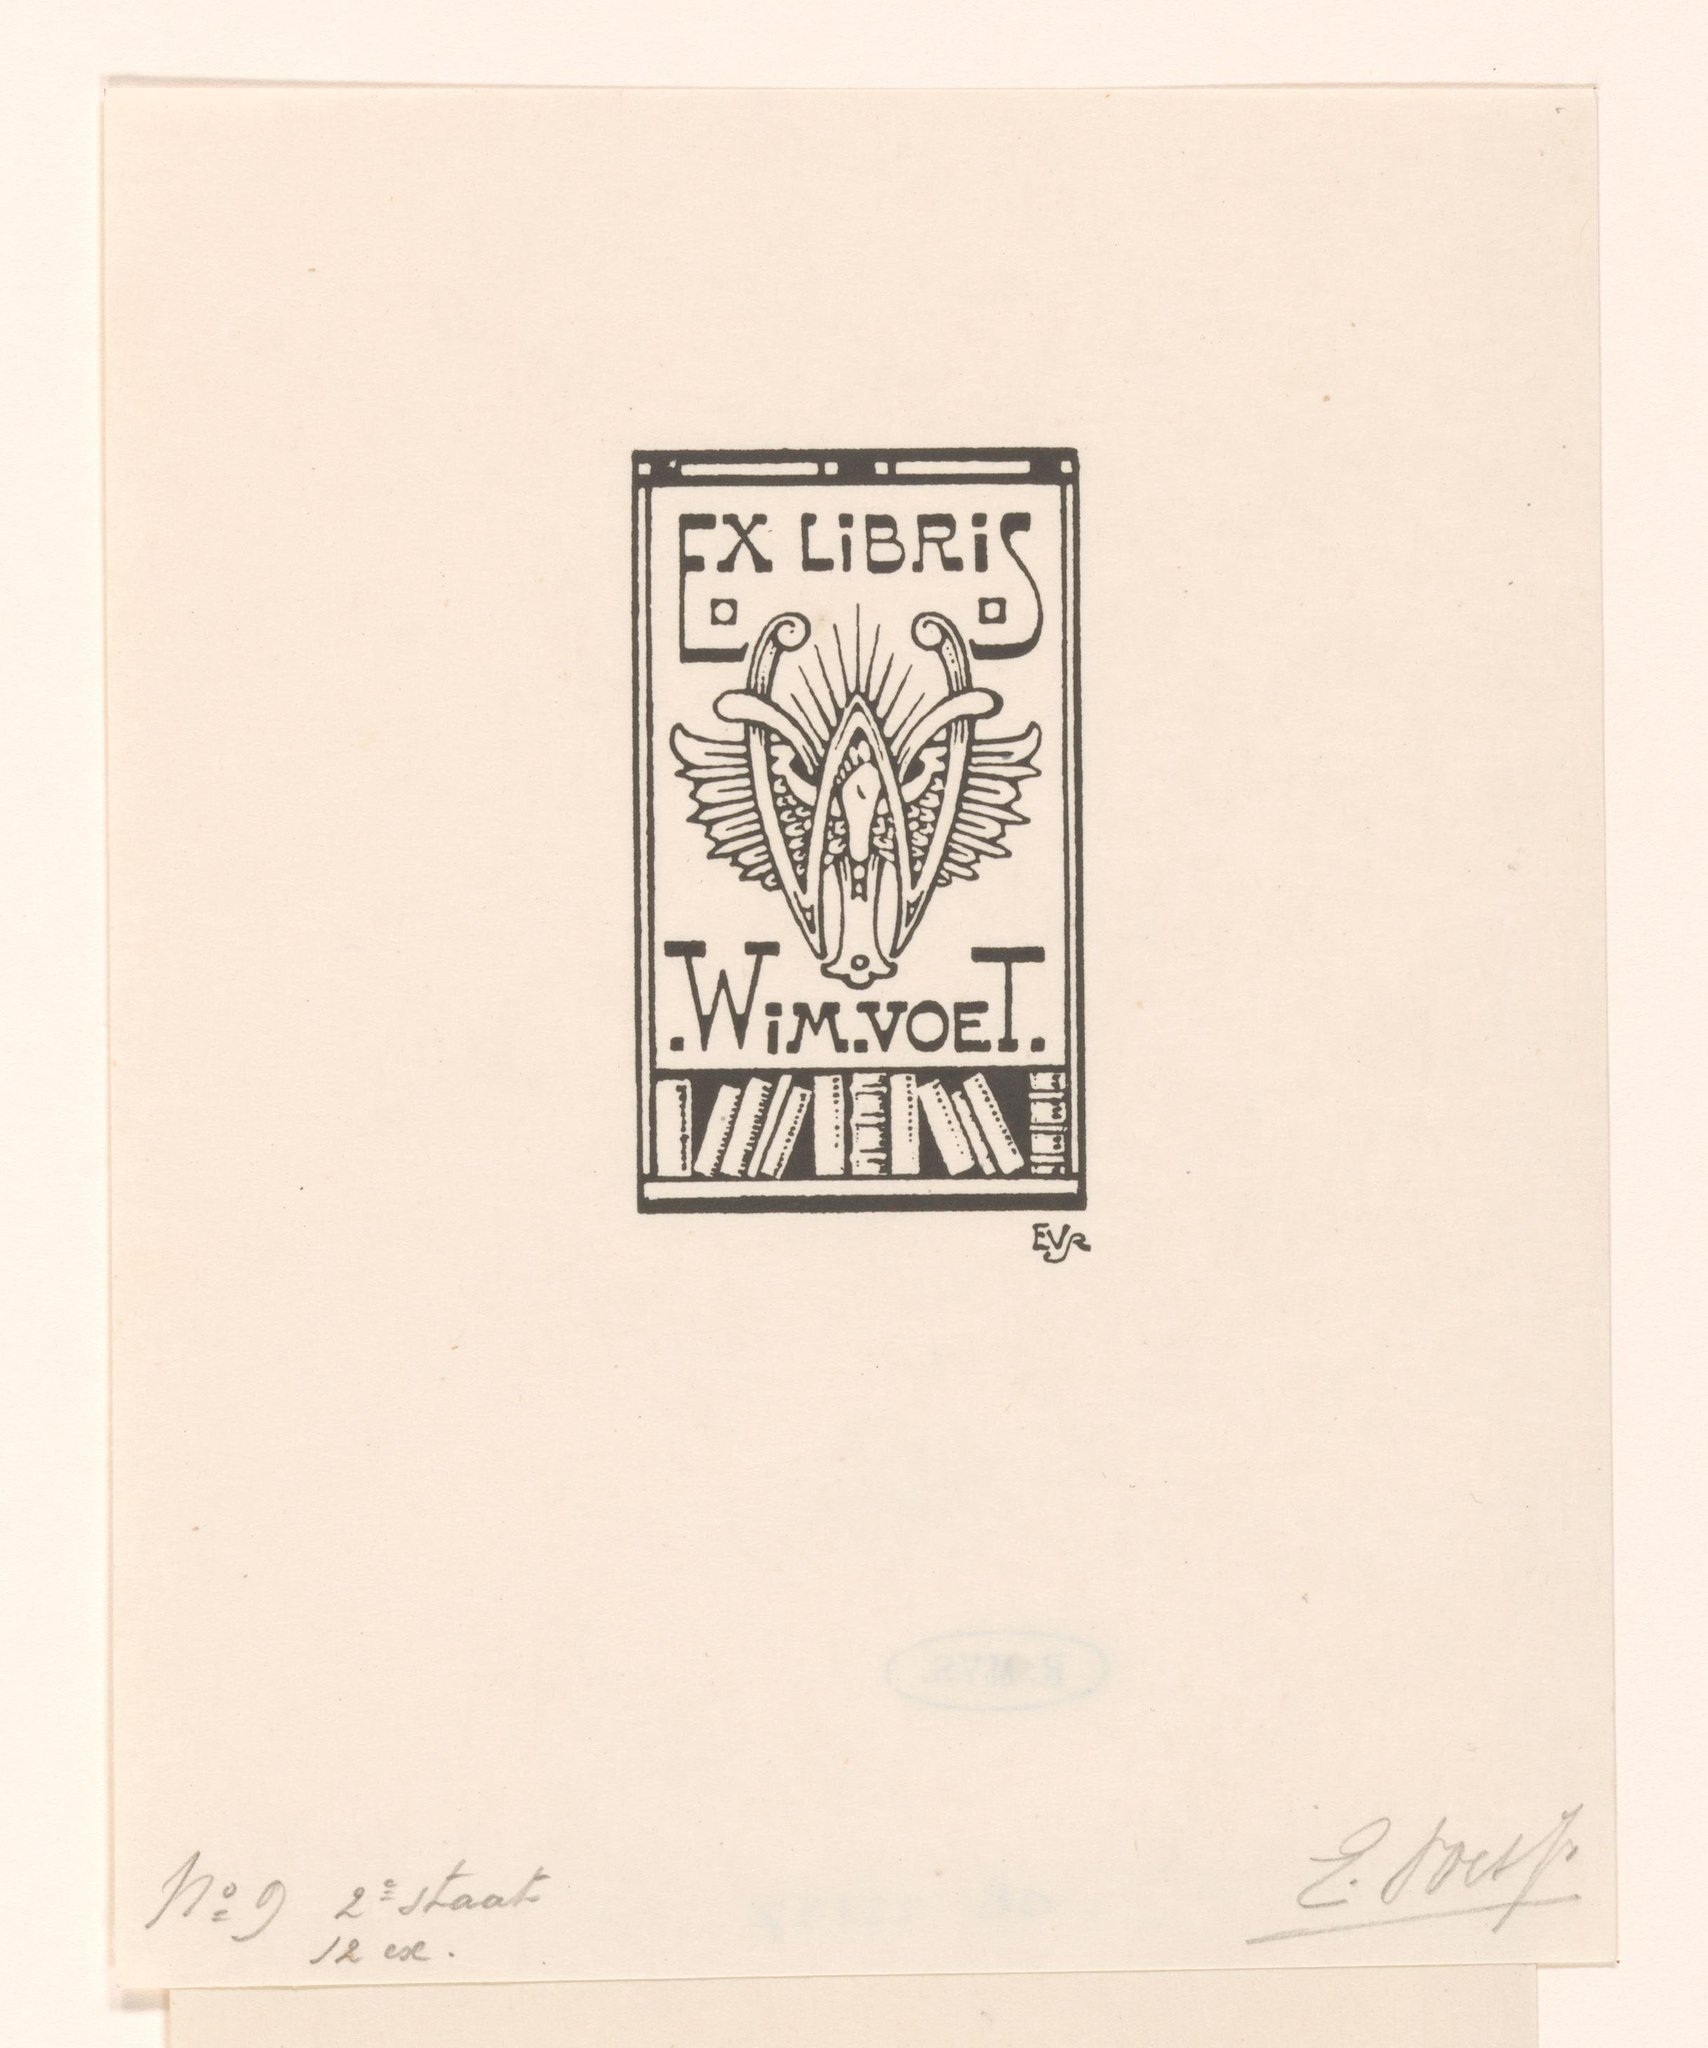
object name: bookplate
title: Ex libris van Wim Voet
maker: elias voet jr.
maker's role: jeweler, print maker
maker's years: 1868-1940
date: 1878-1940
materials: paper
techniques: woodcut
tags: book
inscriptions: collector's mark: Lugt 2228